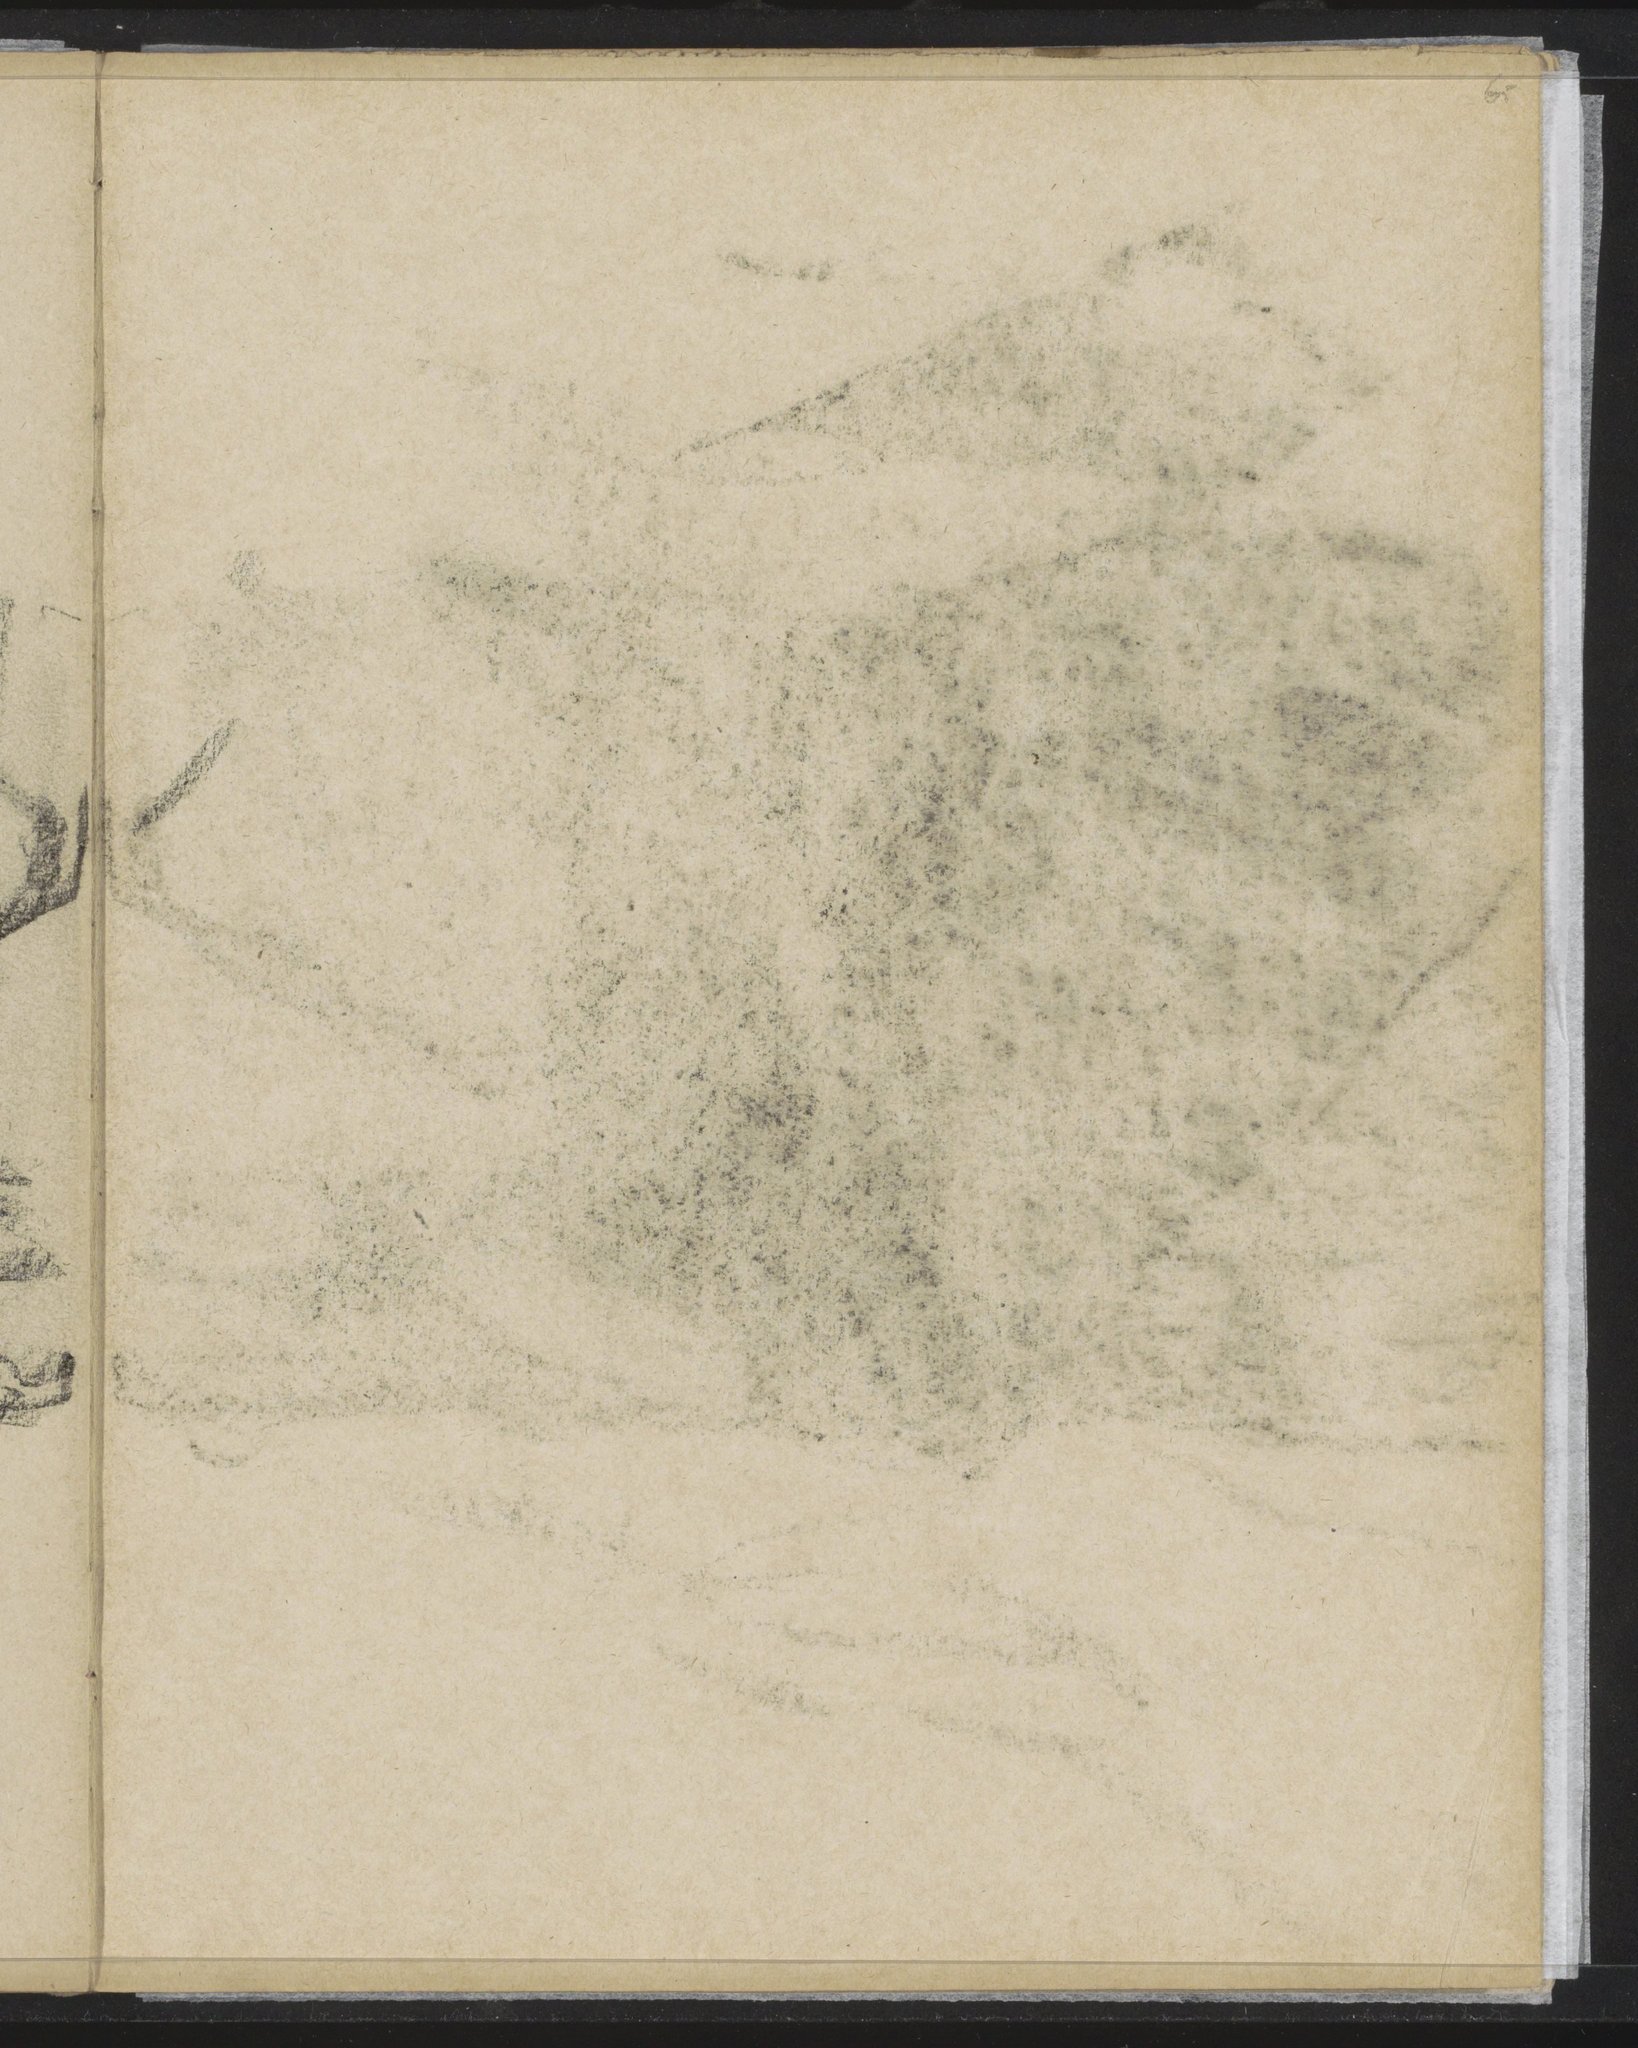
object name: sketchbook leaf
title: Abklatsch van de krijttekening op pagina 64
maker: willem witsen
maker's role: draughtsman, painter, print maker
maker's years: 1860-1923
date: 1884-1891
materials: paper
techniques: printmaking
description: Pagina 65 uit een schetsboek met 49 bladen.